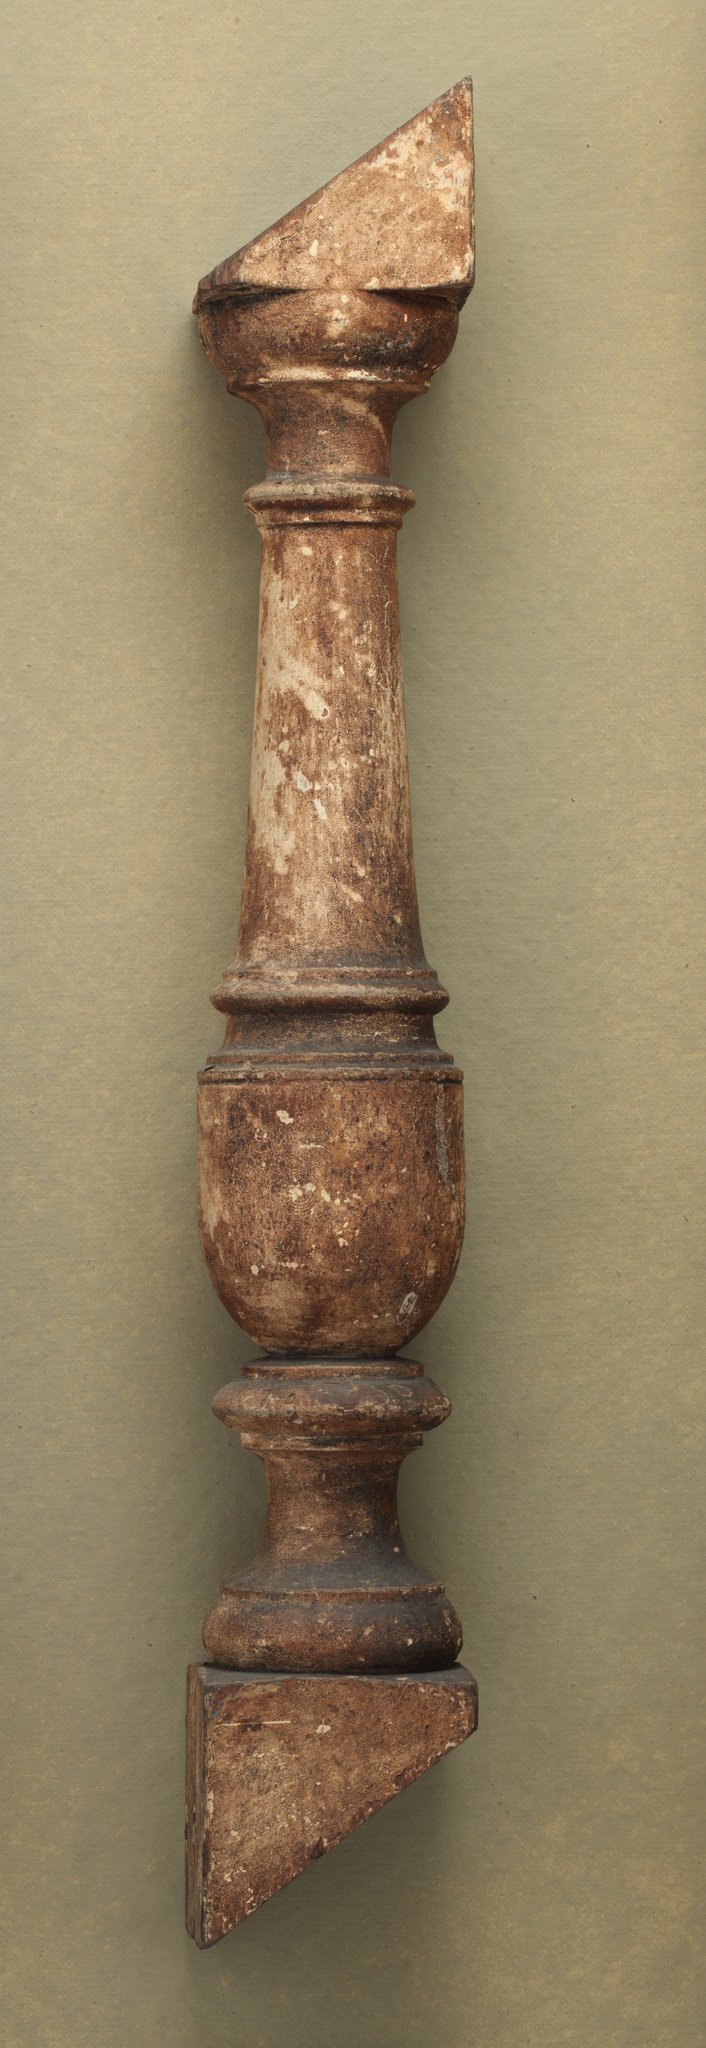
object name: baluster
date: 1651-1700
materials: wood